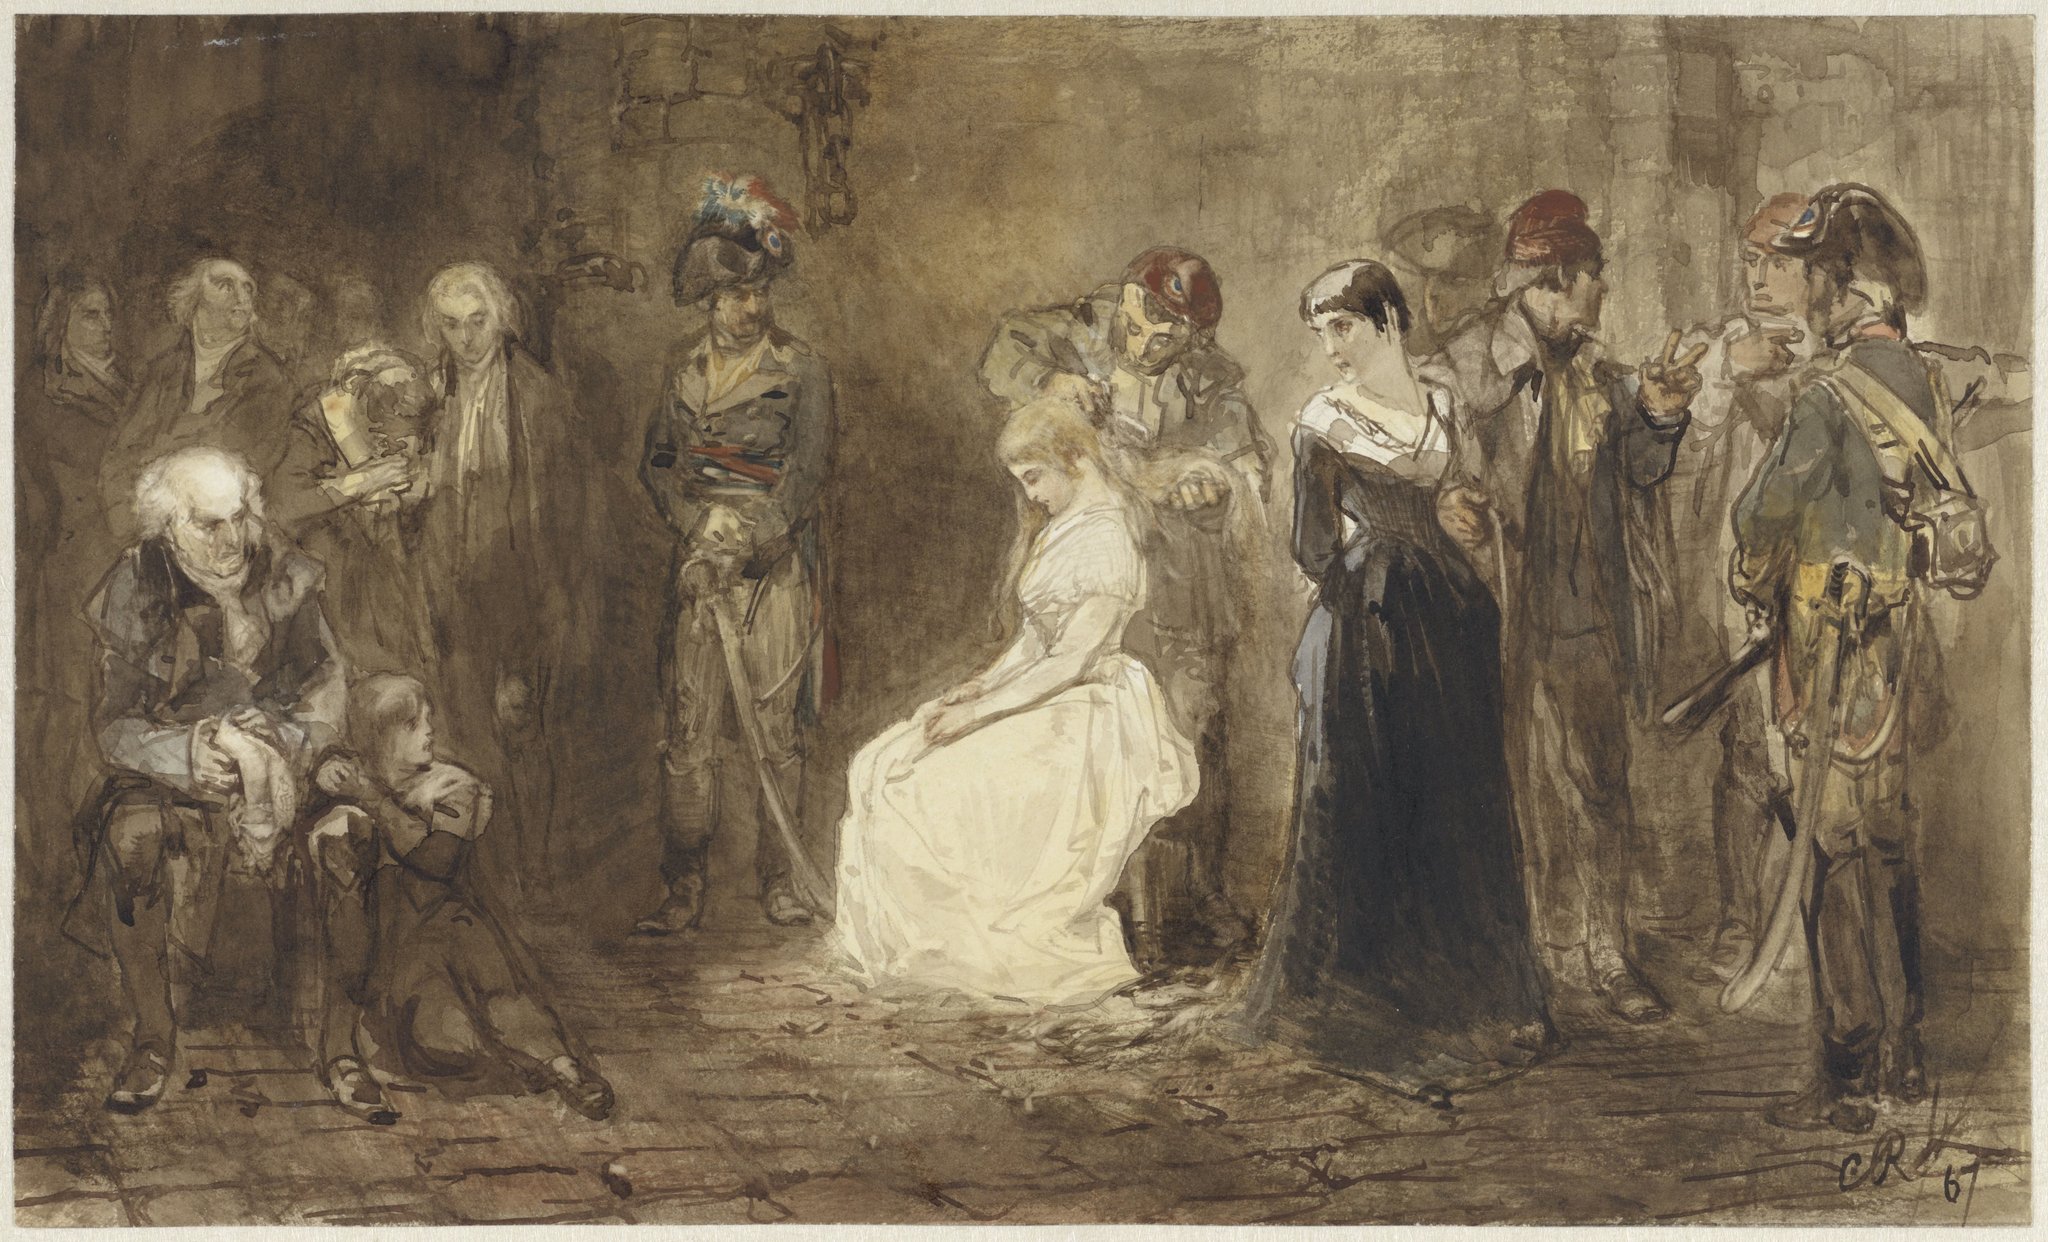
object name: watercolor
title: Prinses Elisabeth van Frankrijk in de gevangenis, 10 mei 1794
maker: charles rochussen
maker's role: draughtsman, painter, print maker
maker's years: 1814-1894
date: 1867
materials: paper, pencil, watercolor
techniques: brush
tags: paris, historical persons, imprisonment, historical events and situations, france